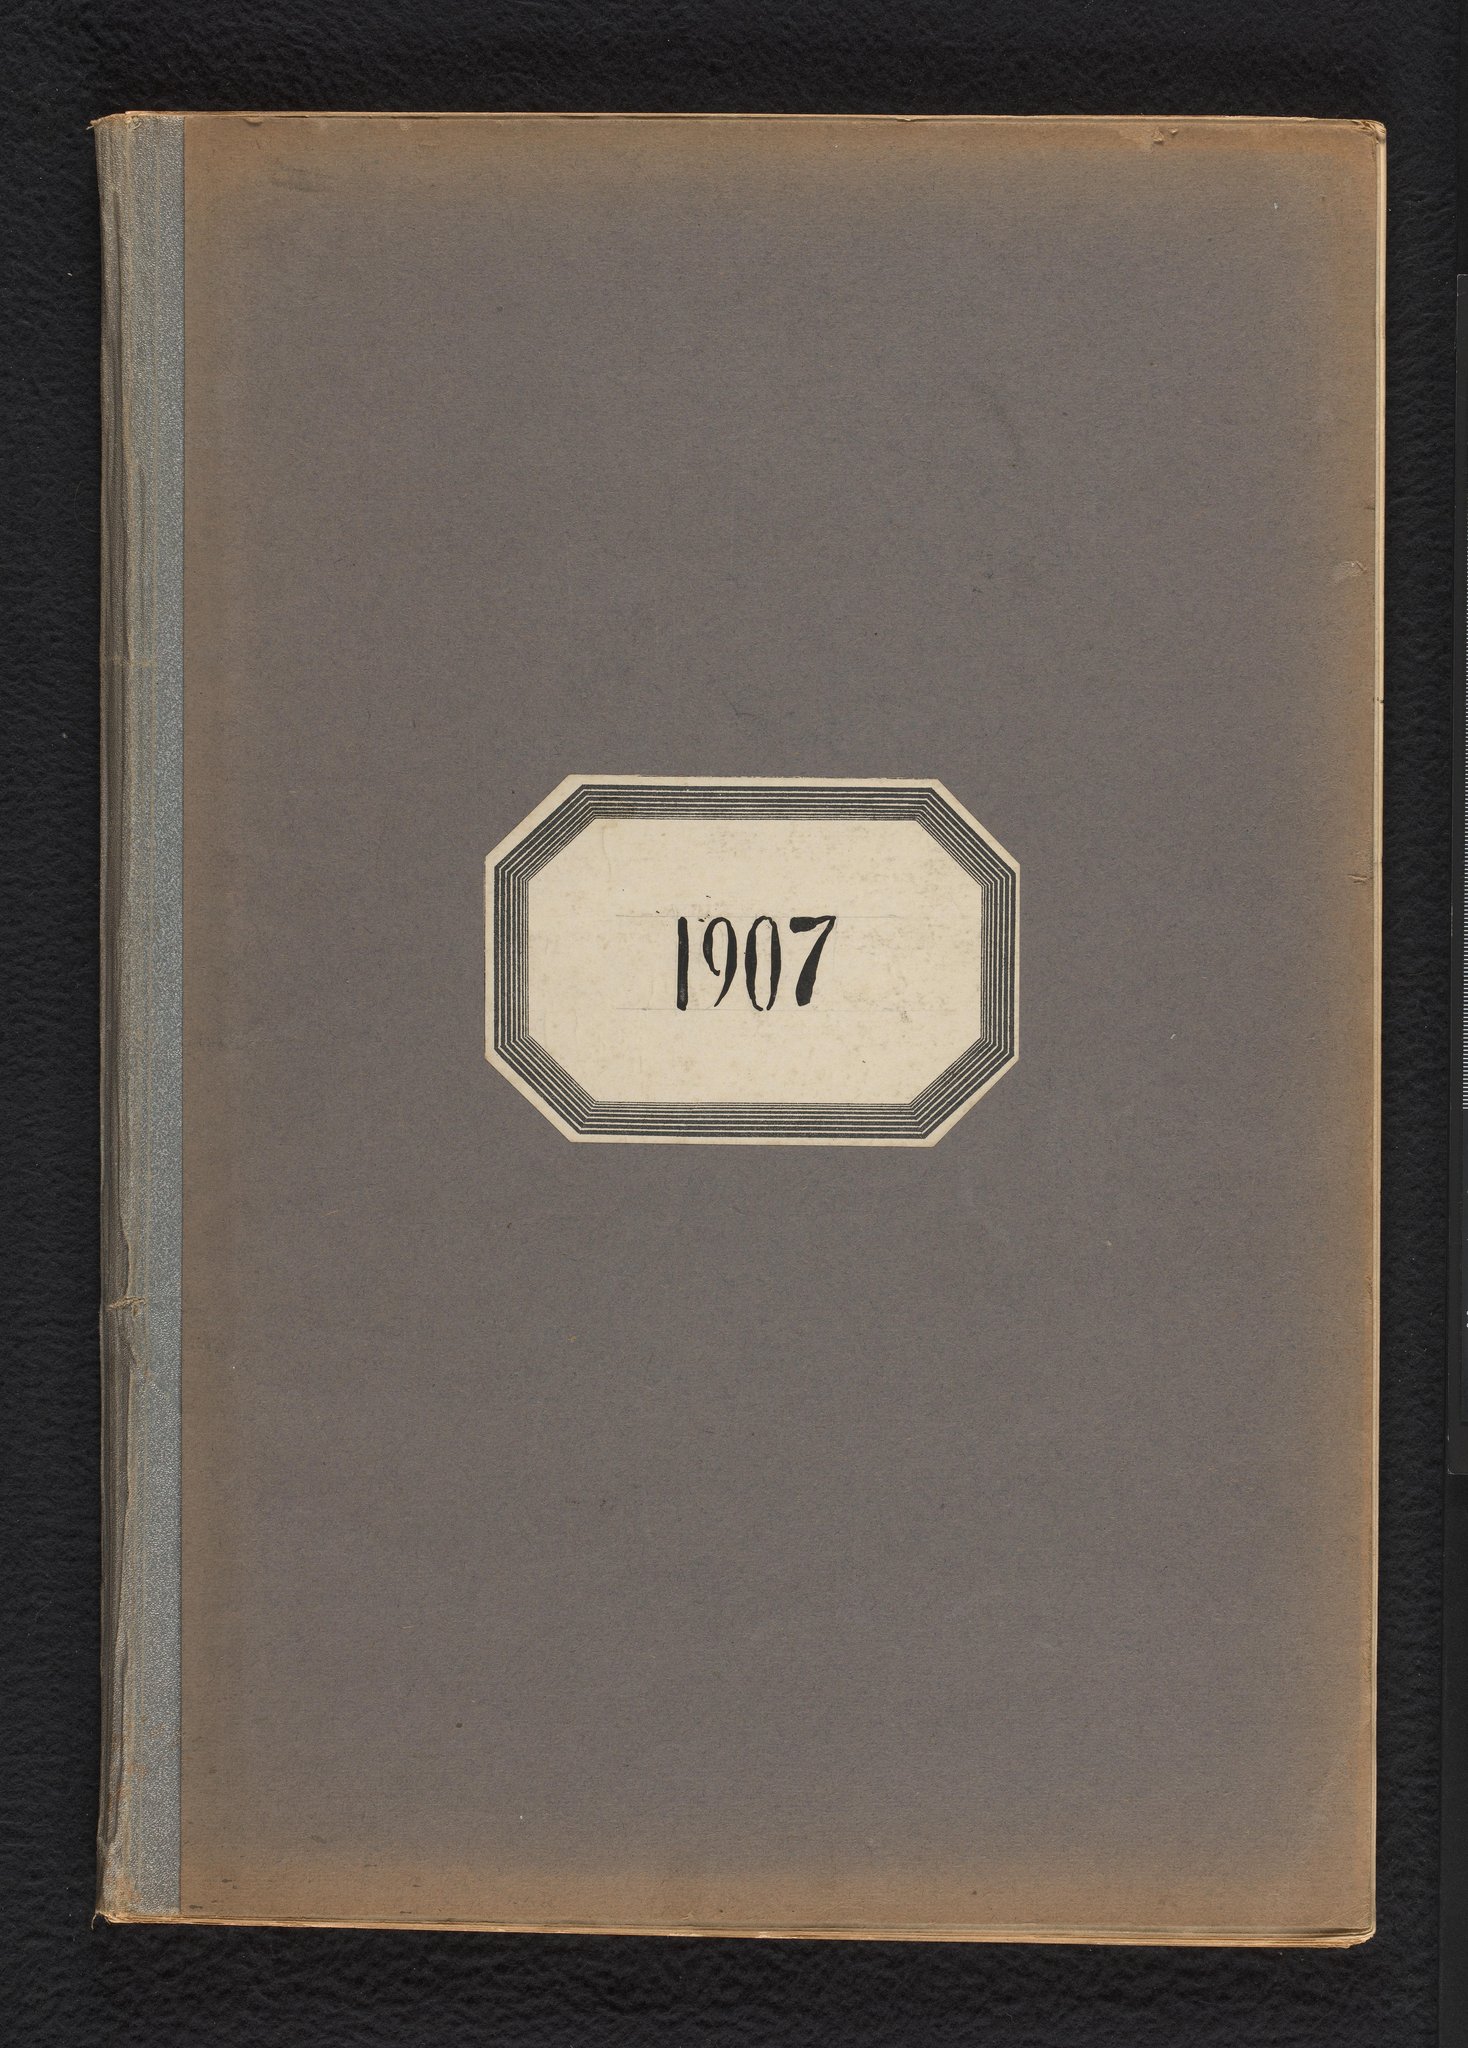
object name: cartoon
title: Spotprenten uit 'De Amsterdammer' van het jaar 1907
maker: johan braakensiek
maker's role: draughtsman, print maker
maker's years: 1858-1940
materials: paper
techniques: lithograph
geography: netherlands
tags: political caricatures and satires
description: Bundel van 49 spotprenten van Braakensiek gepubliceerd als bijvoegsel bij 'De Amsterdammer' in het jaar 1907. Bundel geplakt in slappe omslag van grijsgroen karton met handgeschreven etiket '1907'.